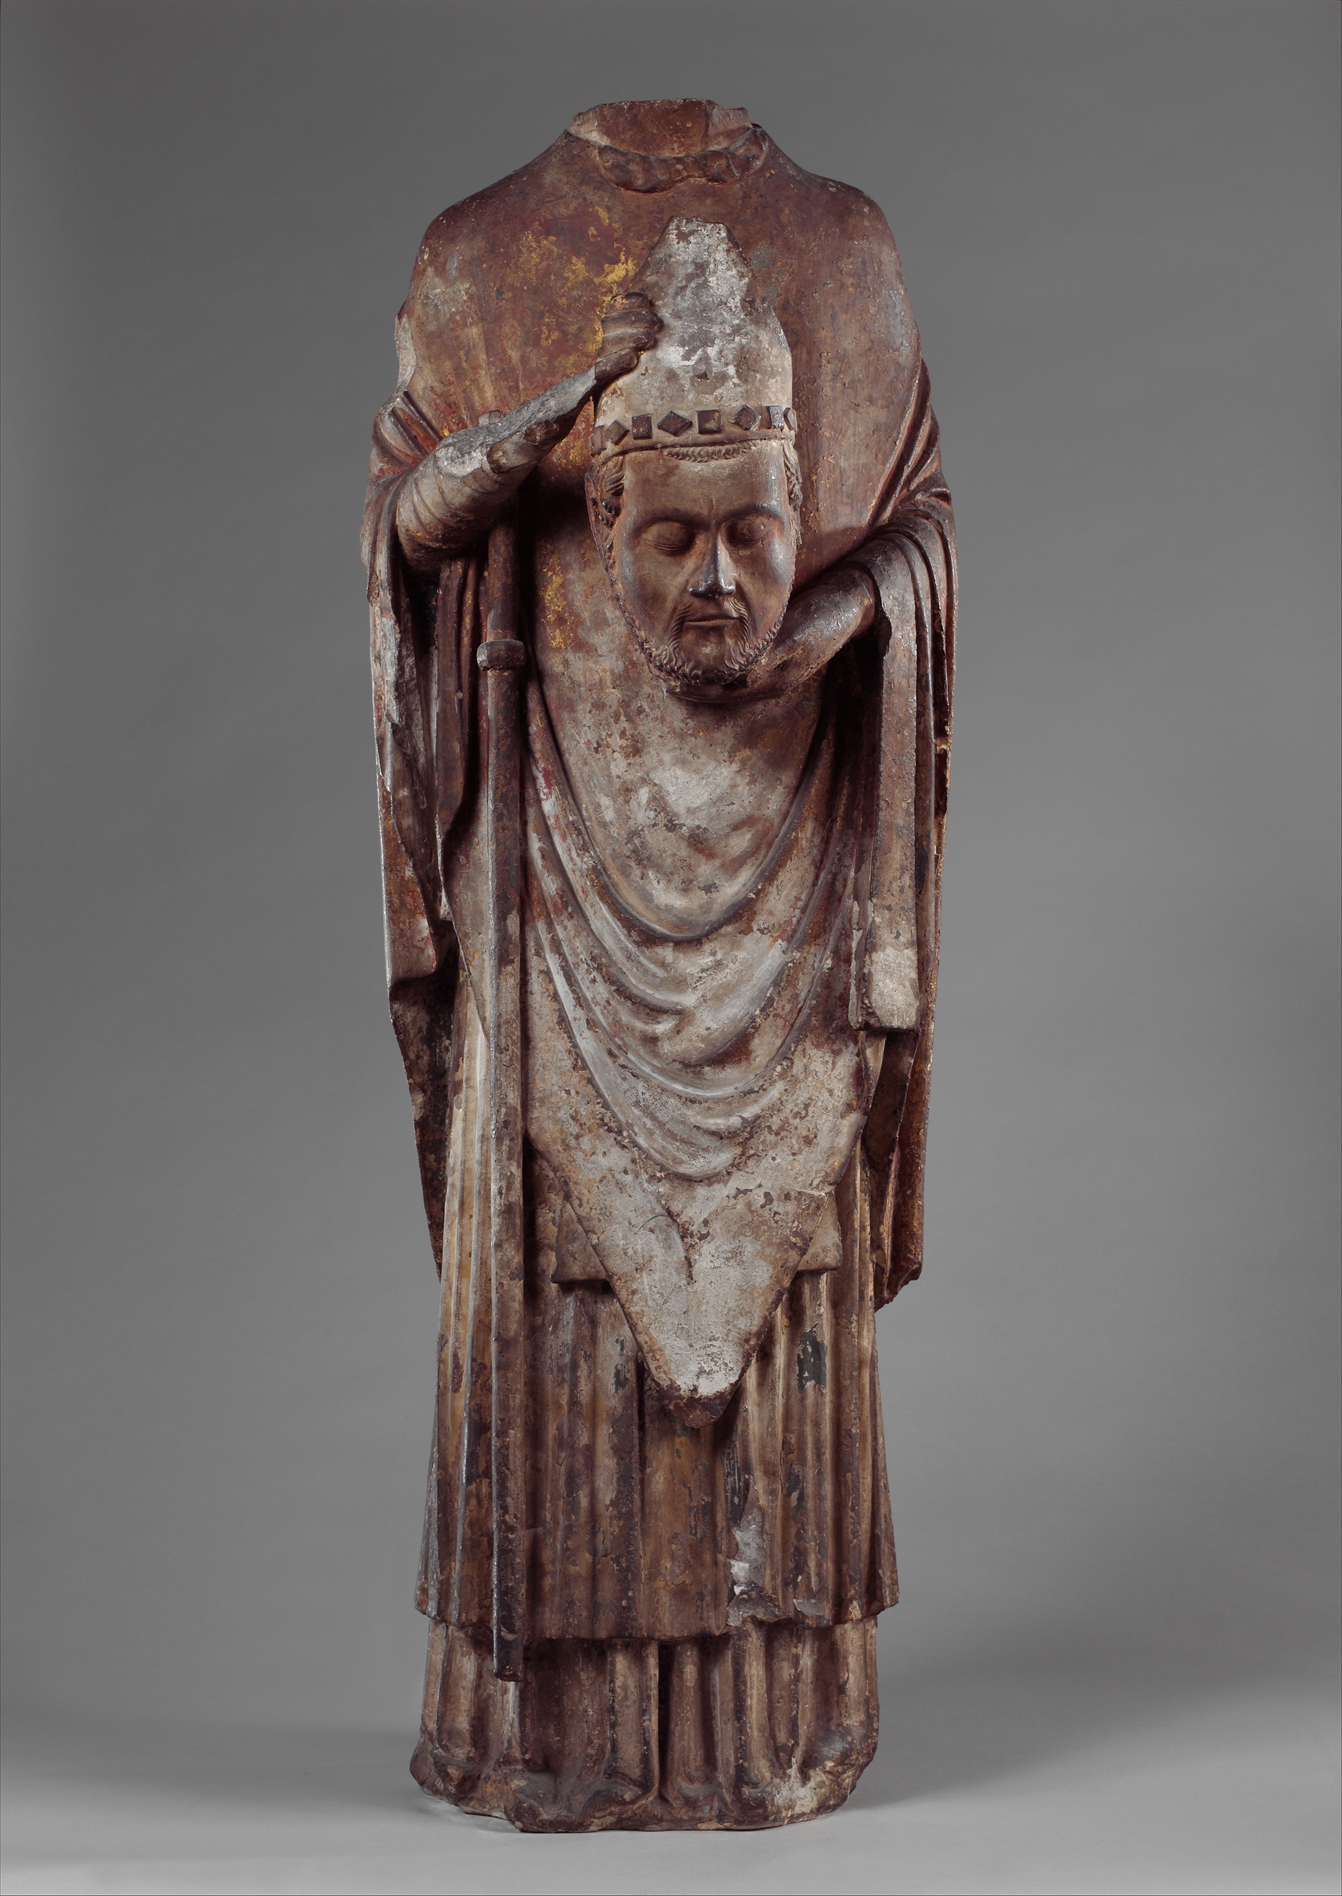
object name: statue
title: Saint Firmin Holding His Head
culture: french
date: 1225-1275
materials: limestone, paint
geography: france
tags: heads,men